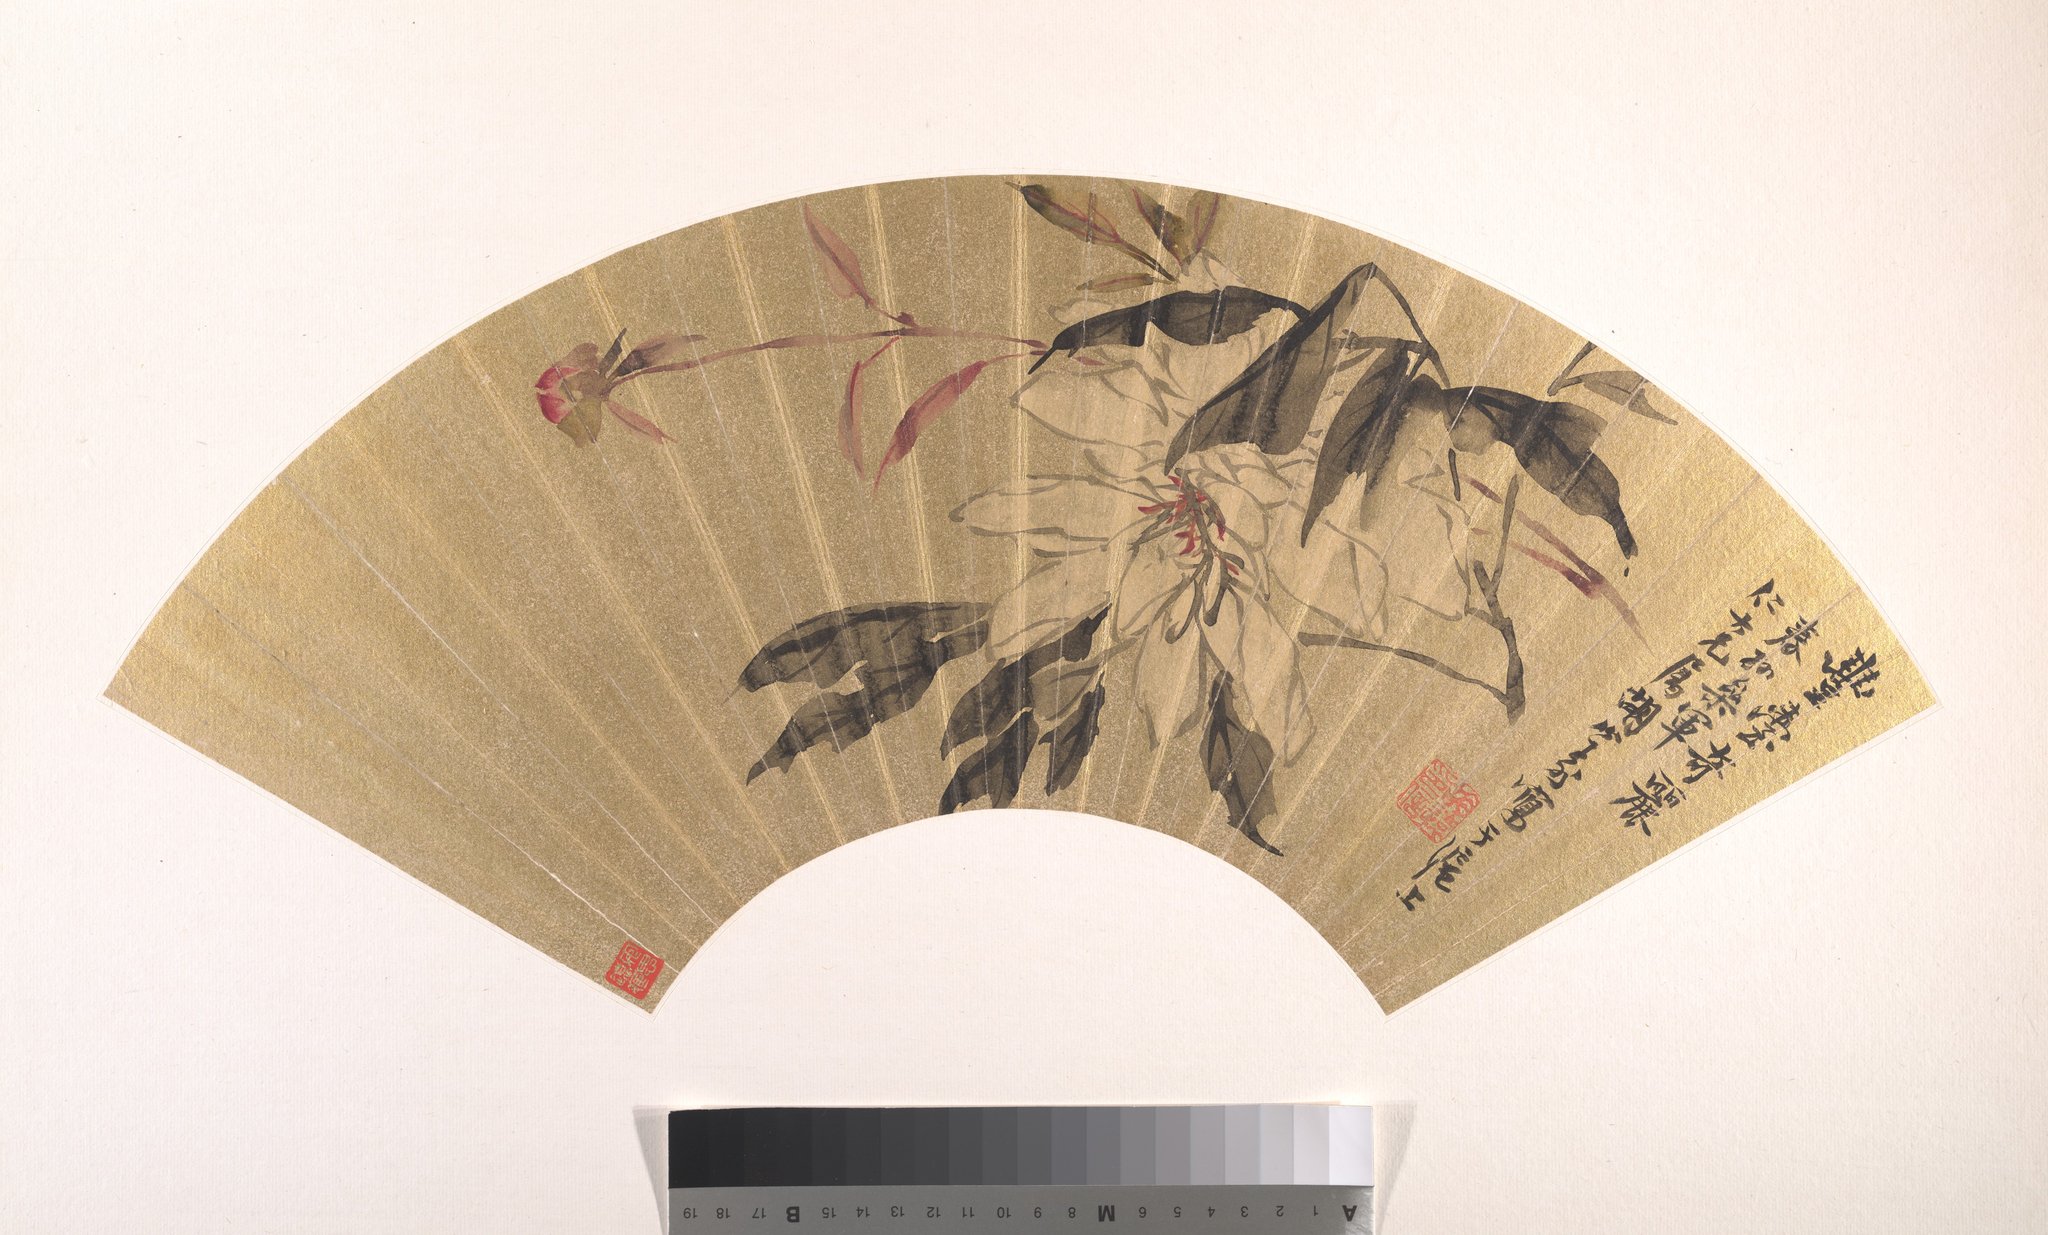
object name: folding fan mounted a an album leaf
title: Herbaceous Peony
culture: chinese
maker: hu yuan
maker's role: artist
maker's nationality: chinese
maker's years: 1823-1886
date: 1823-1886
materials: gold, ink, paper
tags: peonies